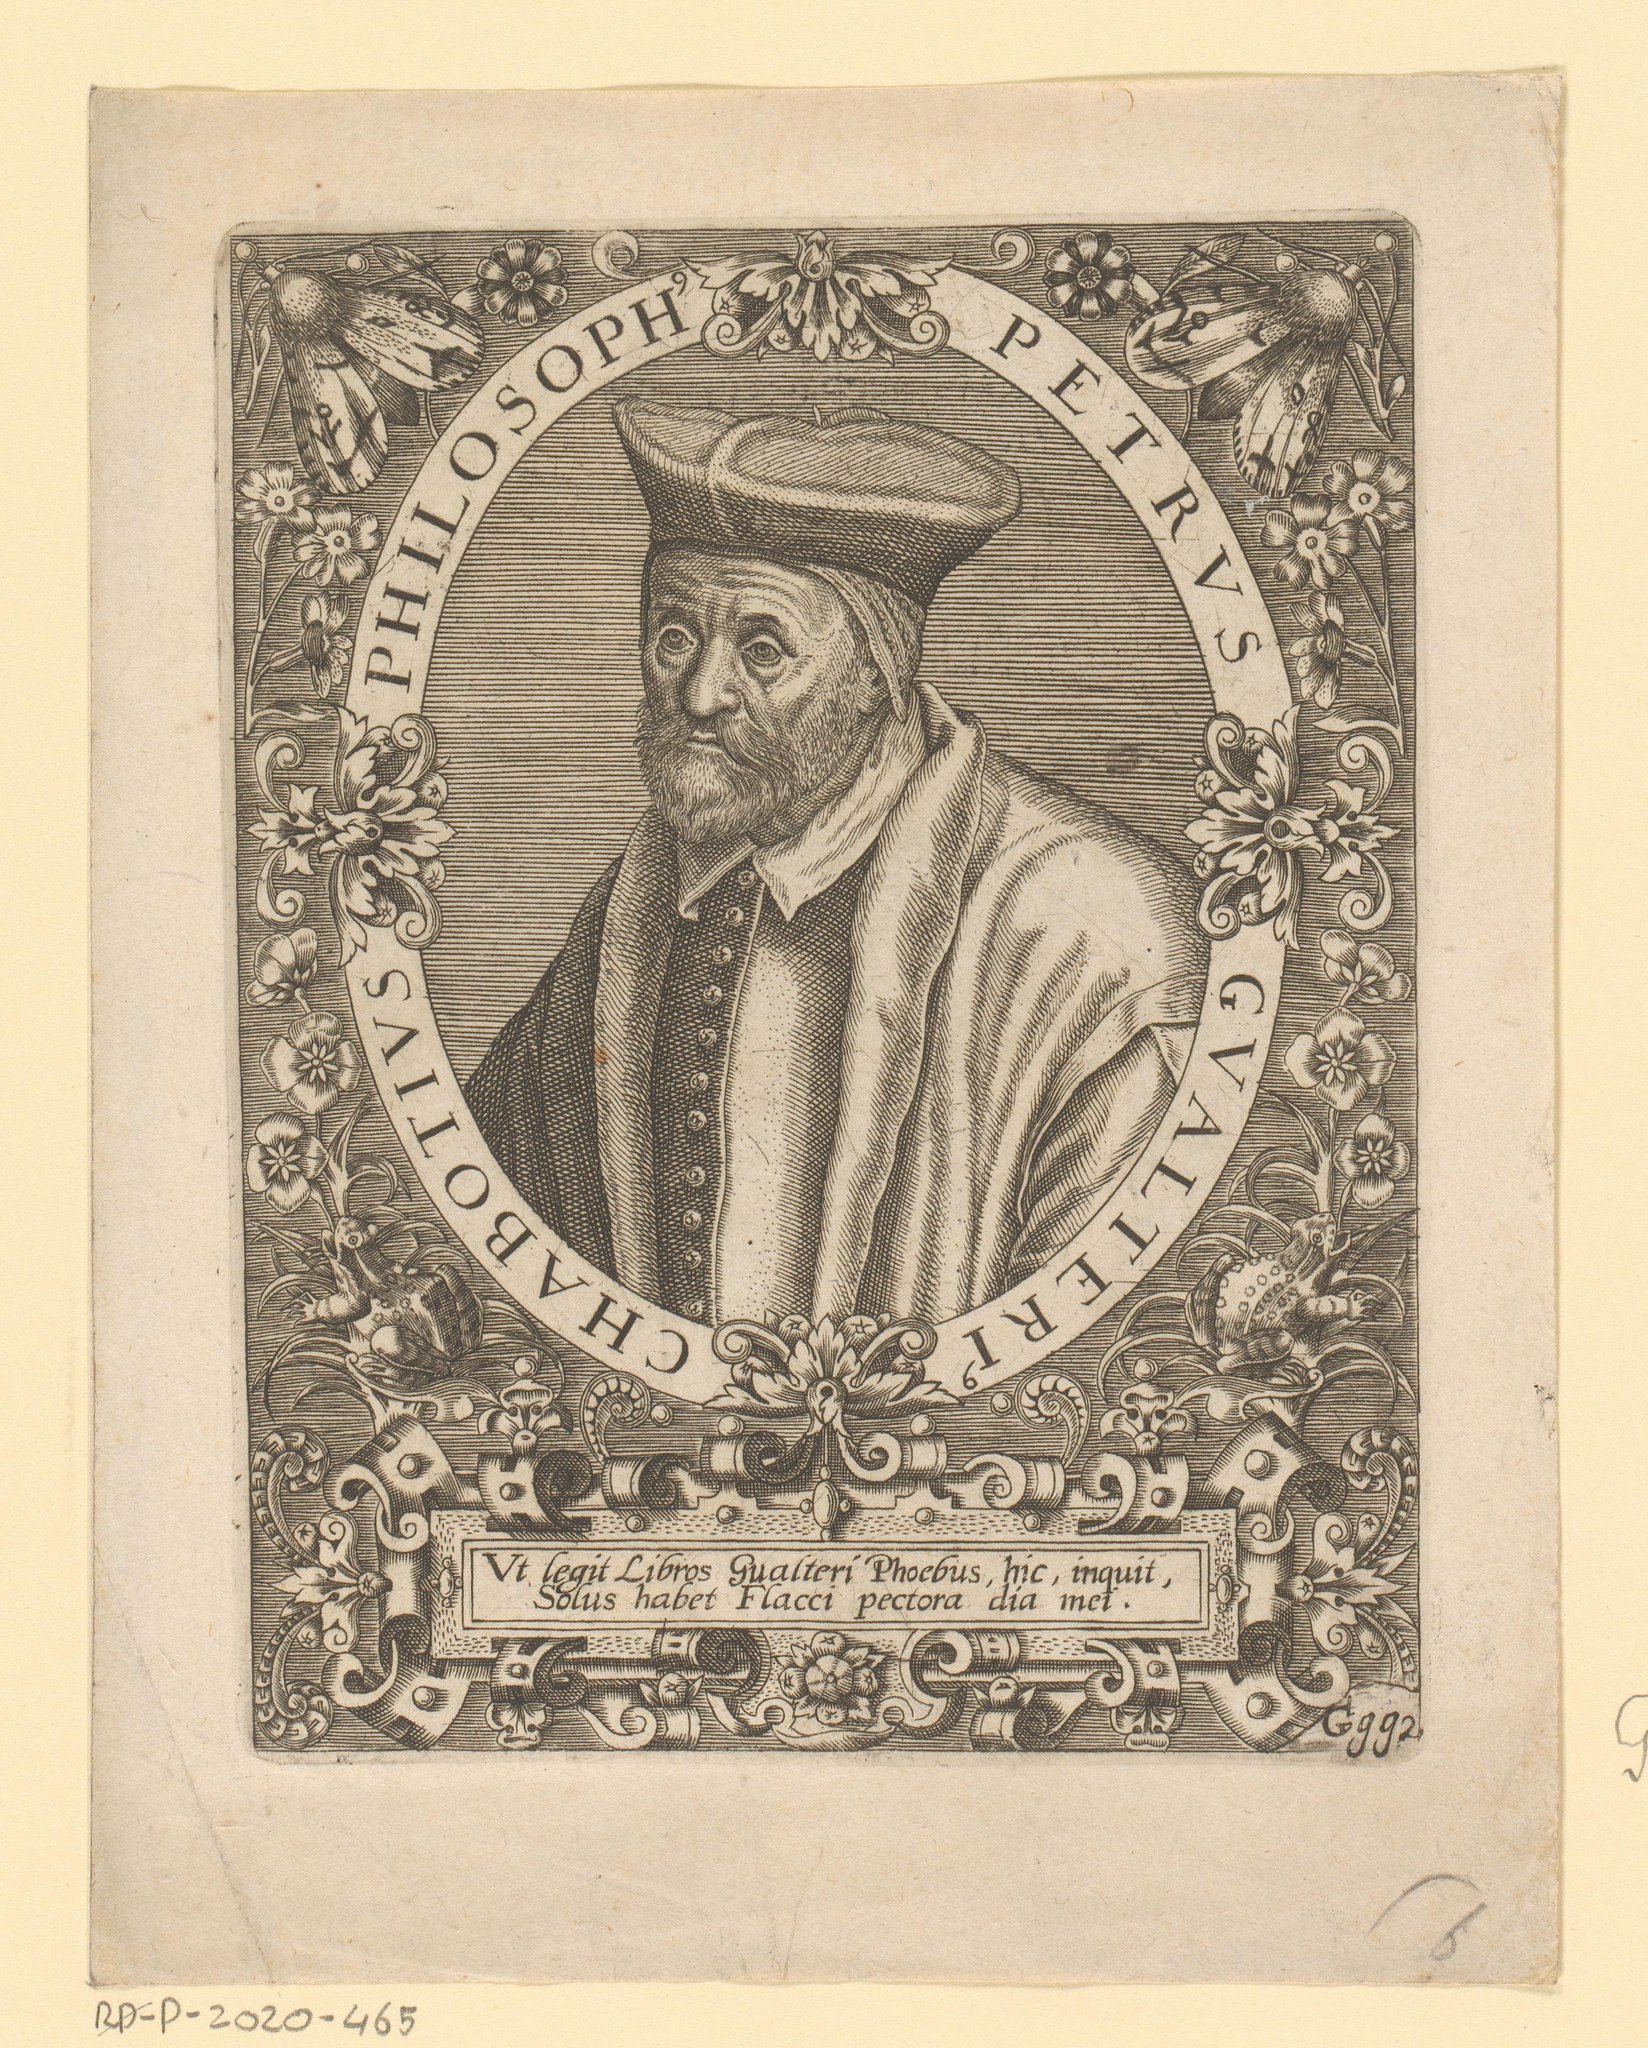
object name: book illustration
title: Petrus Gualteri[9] Chabotius philosoph[9]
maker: jean jacques boissard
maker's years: 1528-1598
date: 1650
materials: paper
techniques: engraving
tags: scholar, philosopher, historical persons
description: Prent gebruikt in: Boissard, Jean Jacques. Bibliotheca chalcographica. 8 dln. Frankfurt am Main: Johannes Ammon, 1650-1652. Ook gebruikt in latere edities. Eerdere staat van prent verschenen in: Boissard, Jean Jacques. Icones quinquaginta virorum illustrium doctrina & eruditione praestantium ad vivum effictae. 4 dln. Frankfurt am Main: s.n., 1597-1599. Mogelijk ook gebruikt in latere edities.